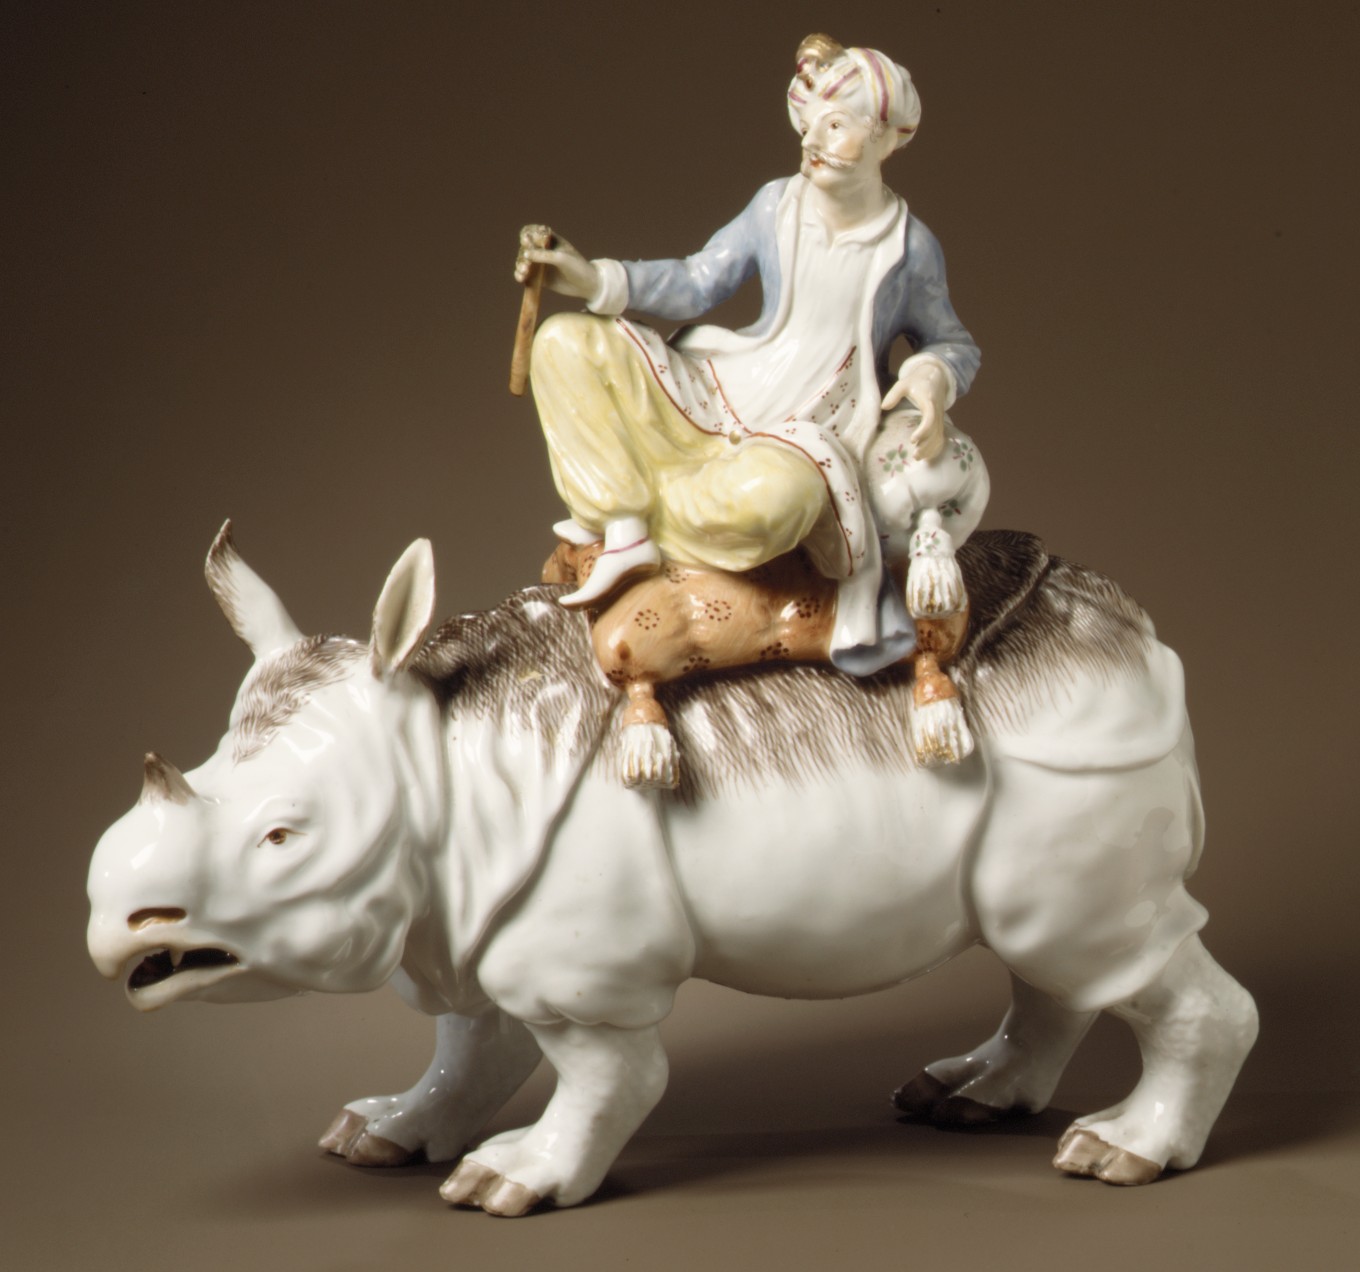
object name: group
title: Turk on a rhinoceros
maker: ludwigsburg porcelain manufactory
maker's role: manufactory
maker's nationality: german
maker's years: 1758-1824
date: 1755-1760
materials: gilt bronze, hard paste porcelain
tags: men,rhinoceros